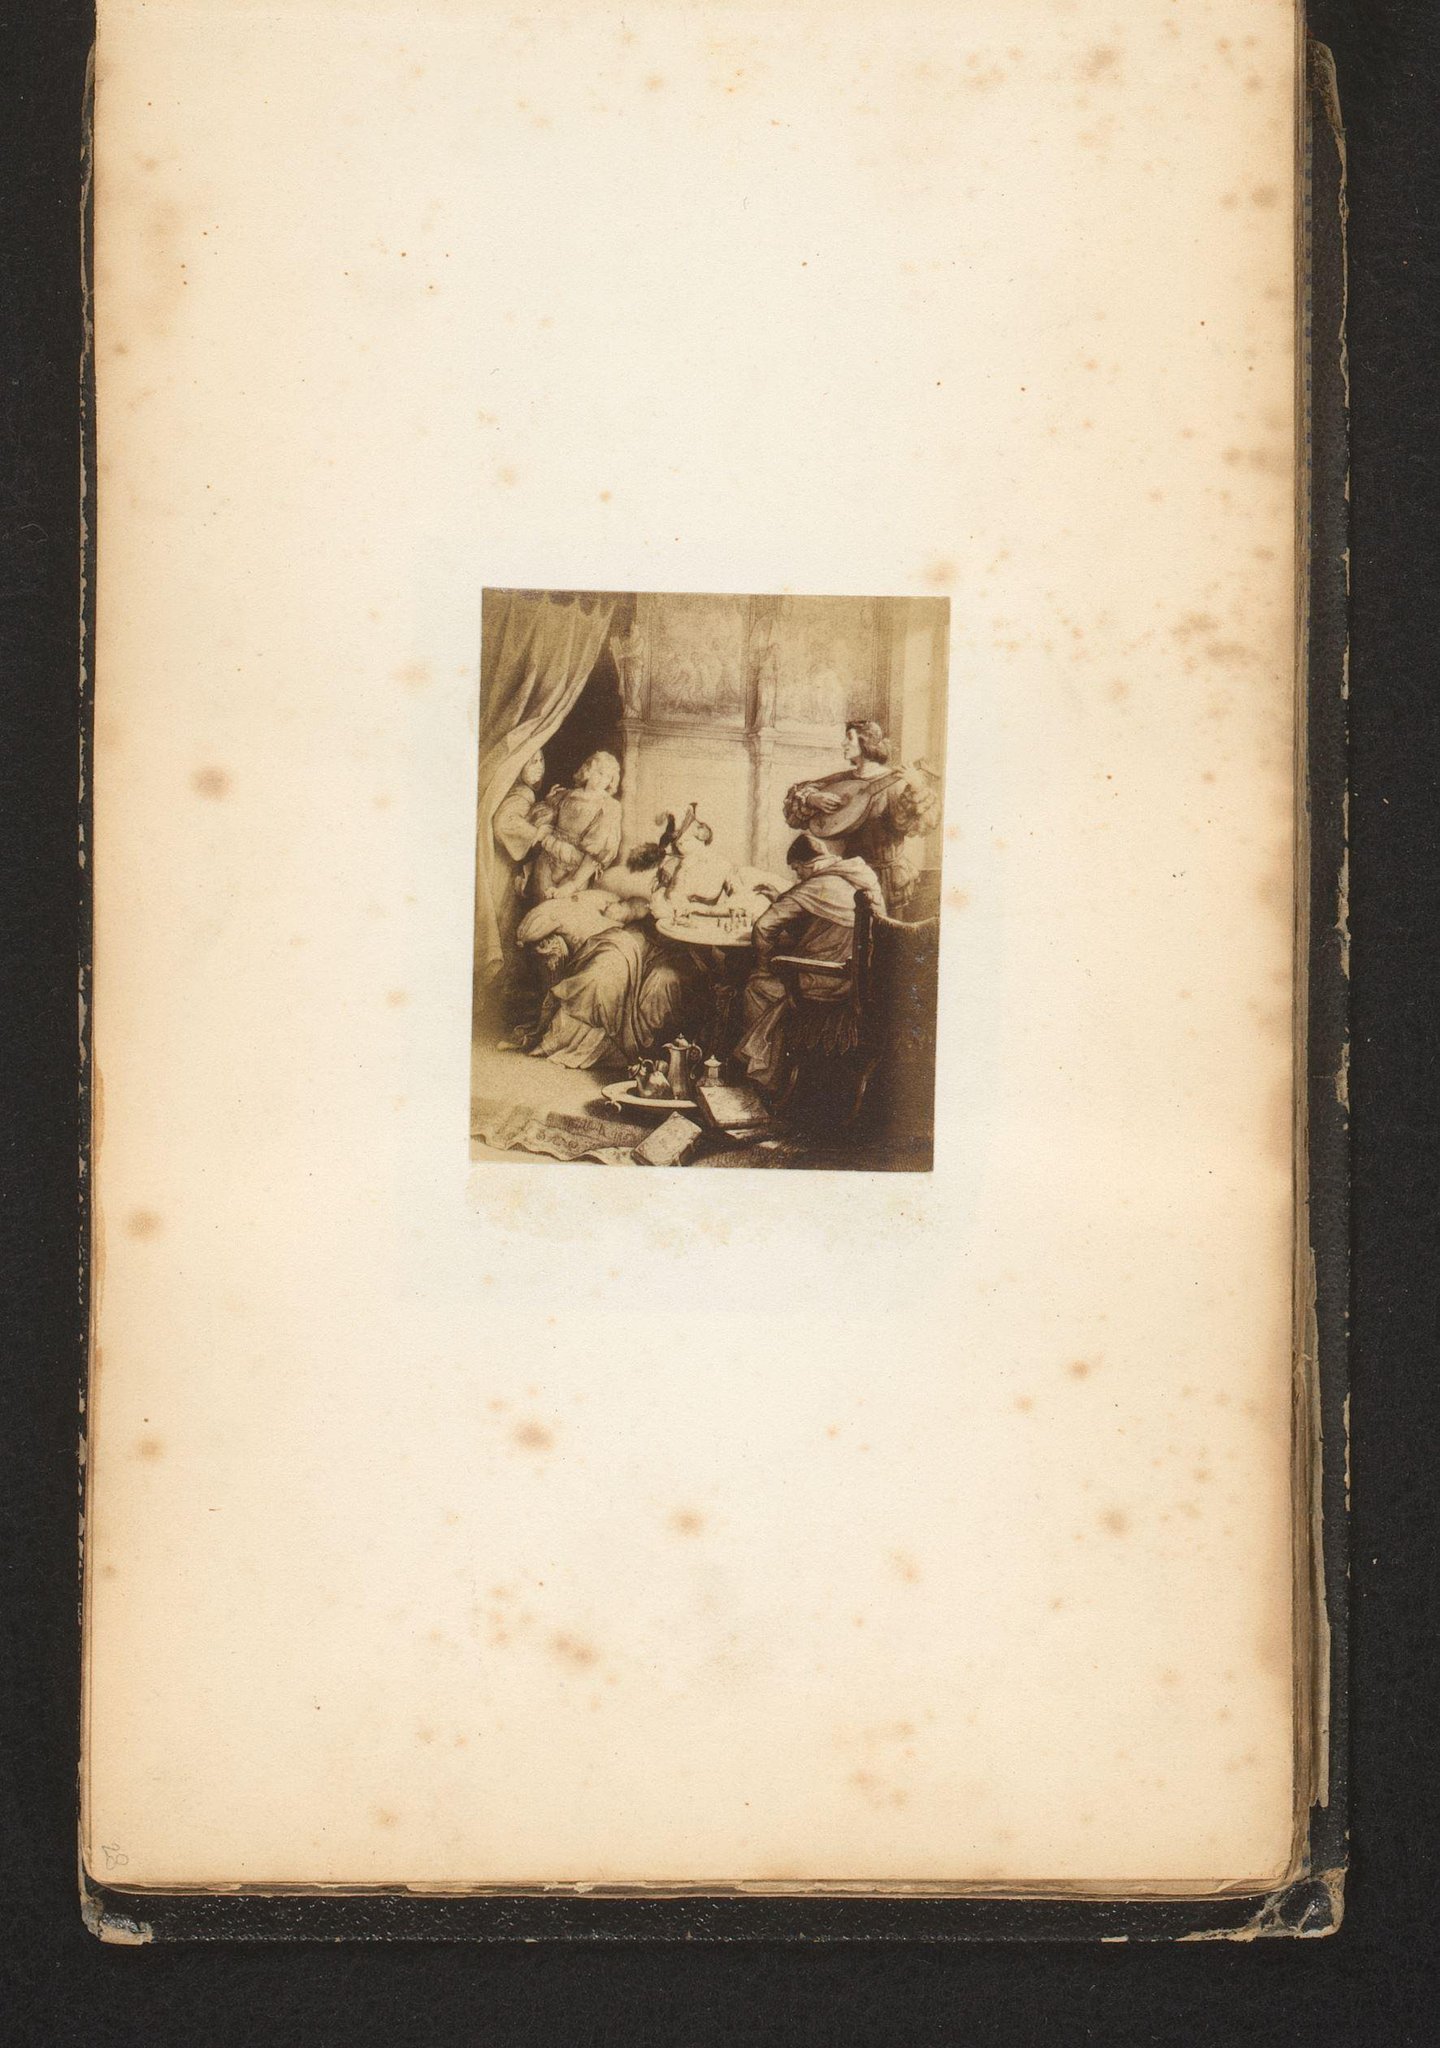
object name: album leaf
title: Fotoreproductie van een schilderij van een schakende man en vrouw en een muzikant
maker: Anonymous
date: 1860-1900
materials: photographic support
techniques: albumen print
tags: musician at work, adult woman, chess, adult man, painting, drawing and the graphic arts